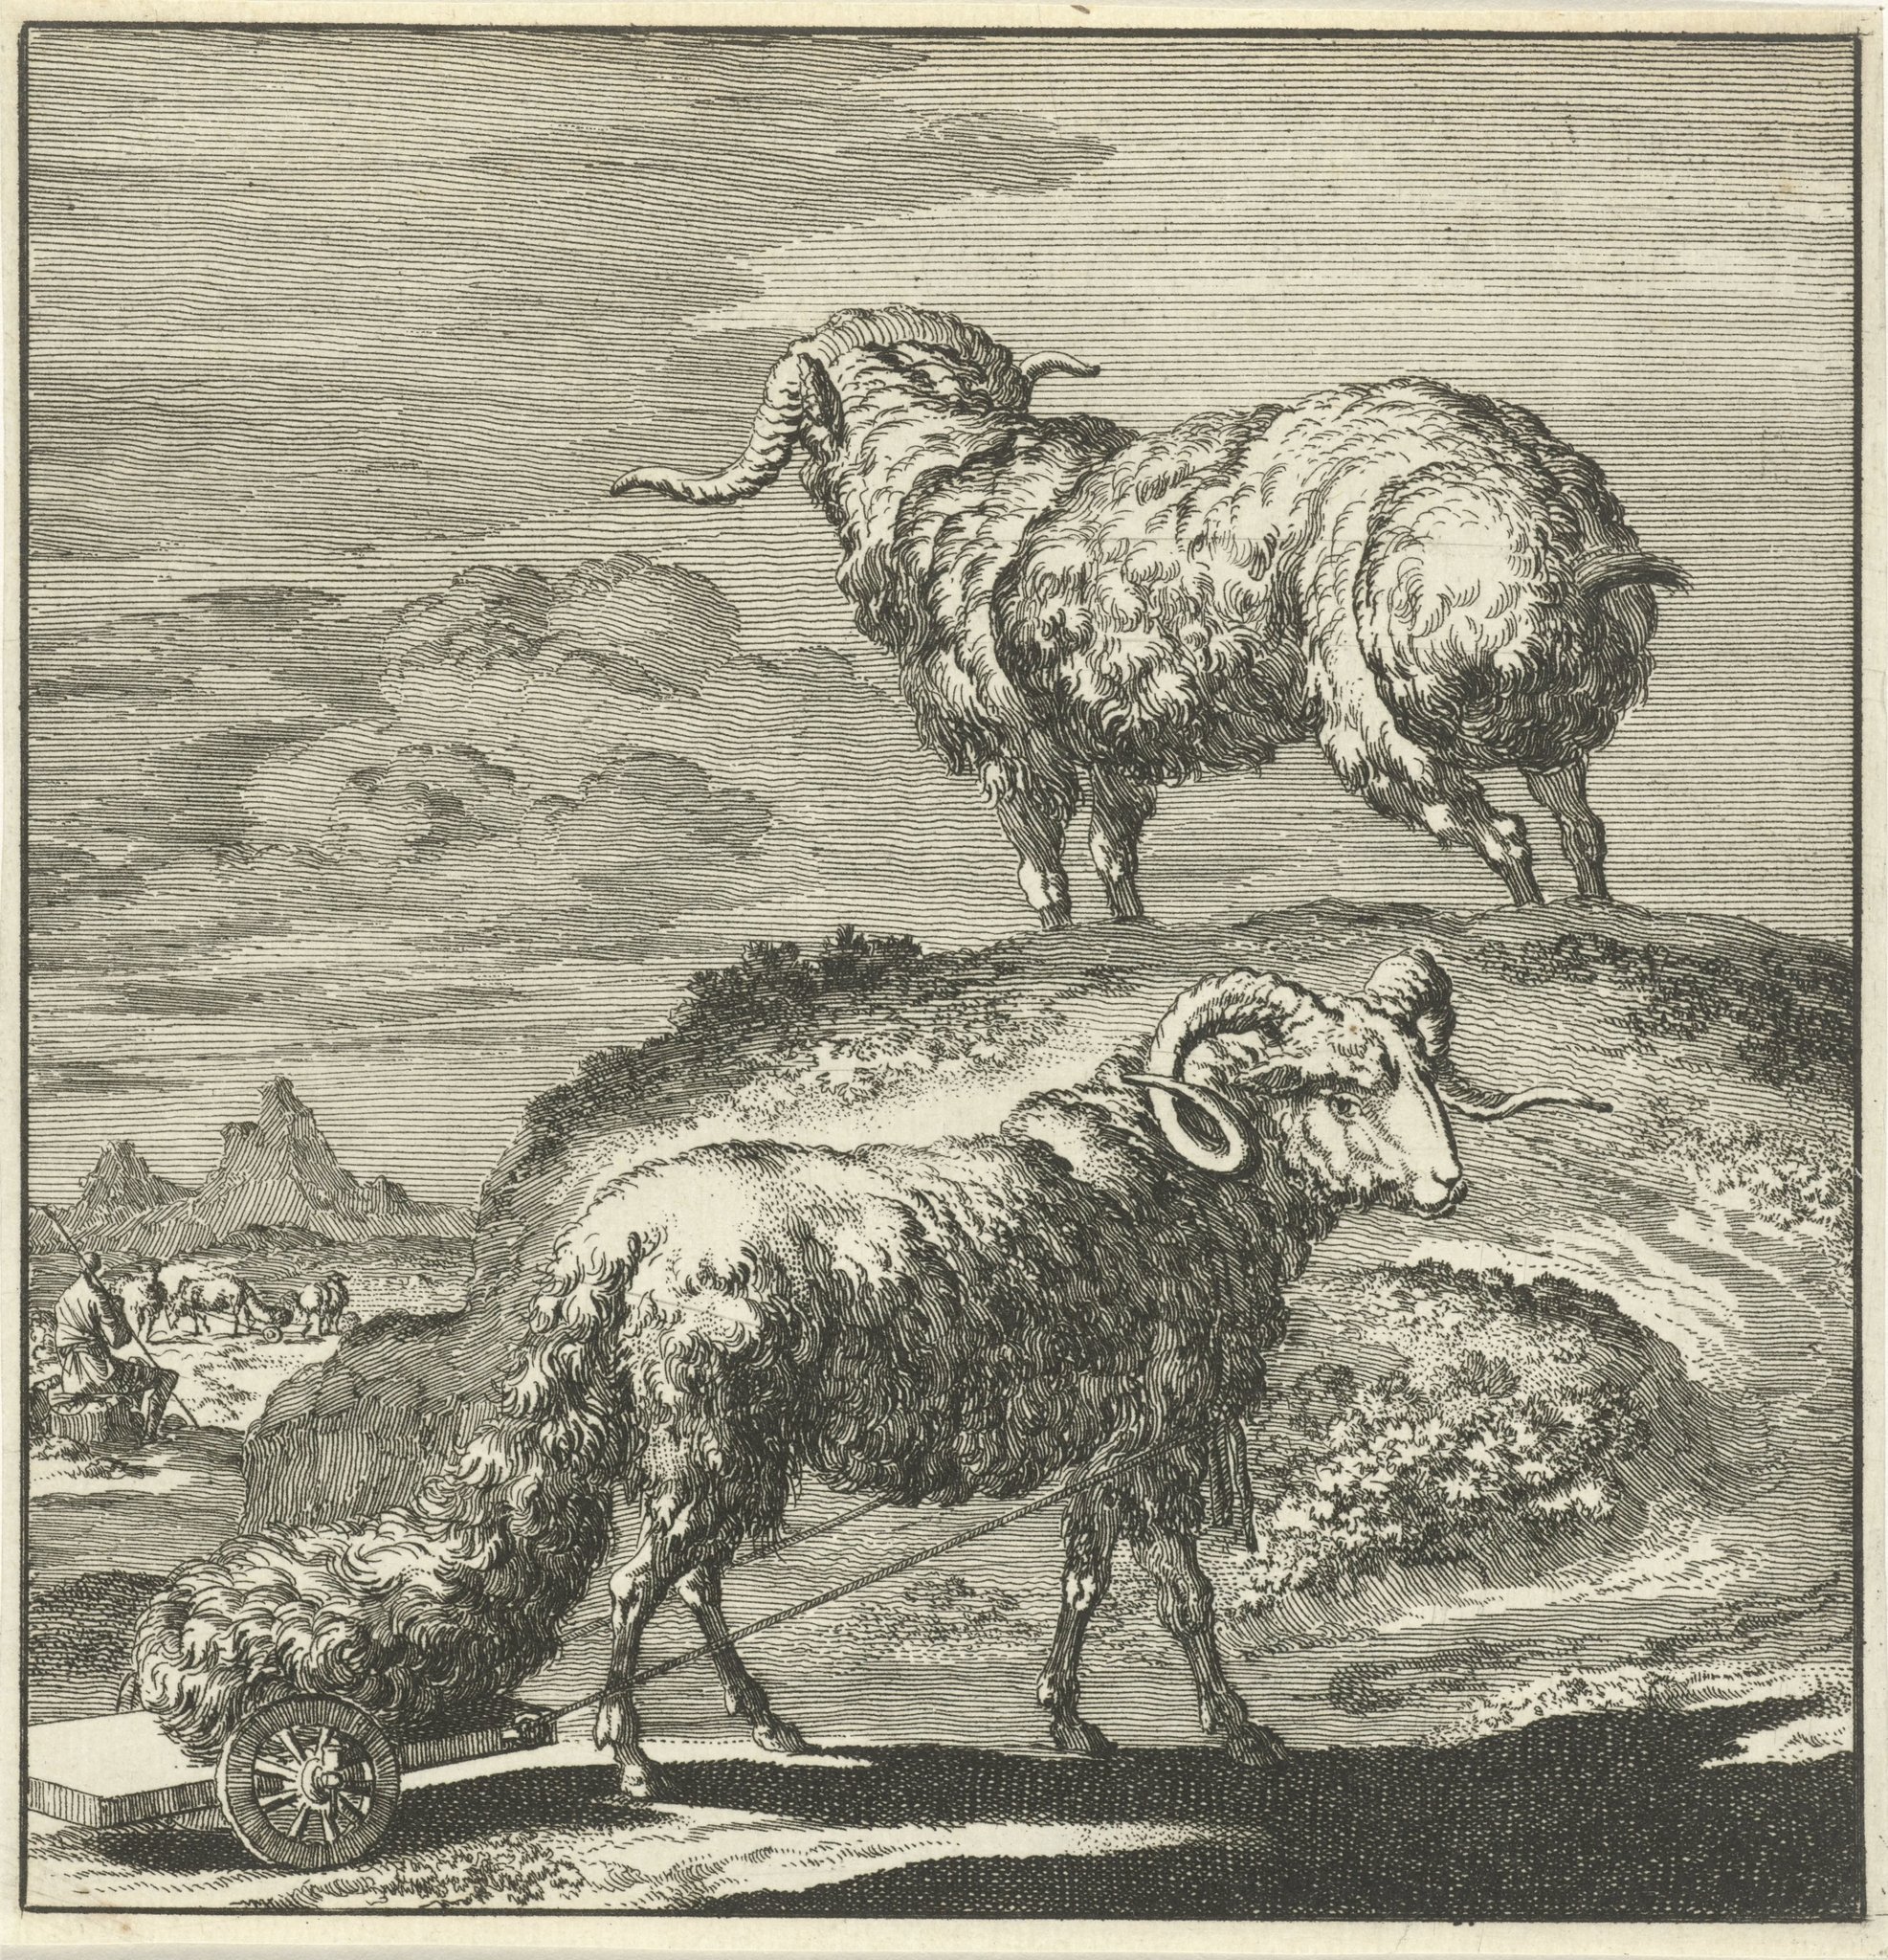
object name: print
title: Syrische schapen of rammen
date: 1683-1762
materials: paper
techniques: etching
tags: sheep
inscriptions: collector's mark: Lugt 2228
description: Originele illustratie opgenomen in: Cunaeus, Petrus. De republyk der Hebreen, of gemeenebest der joden, 3 delen. Amsterdam: Wilhelmus Goeree, 1683, dl. 3, p. 360.